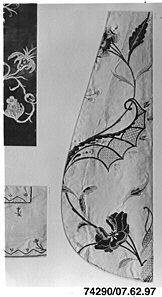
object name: fragment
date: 1701-1800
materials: silk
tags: flowers,leaves